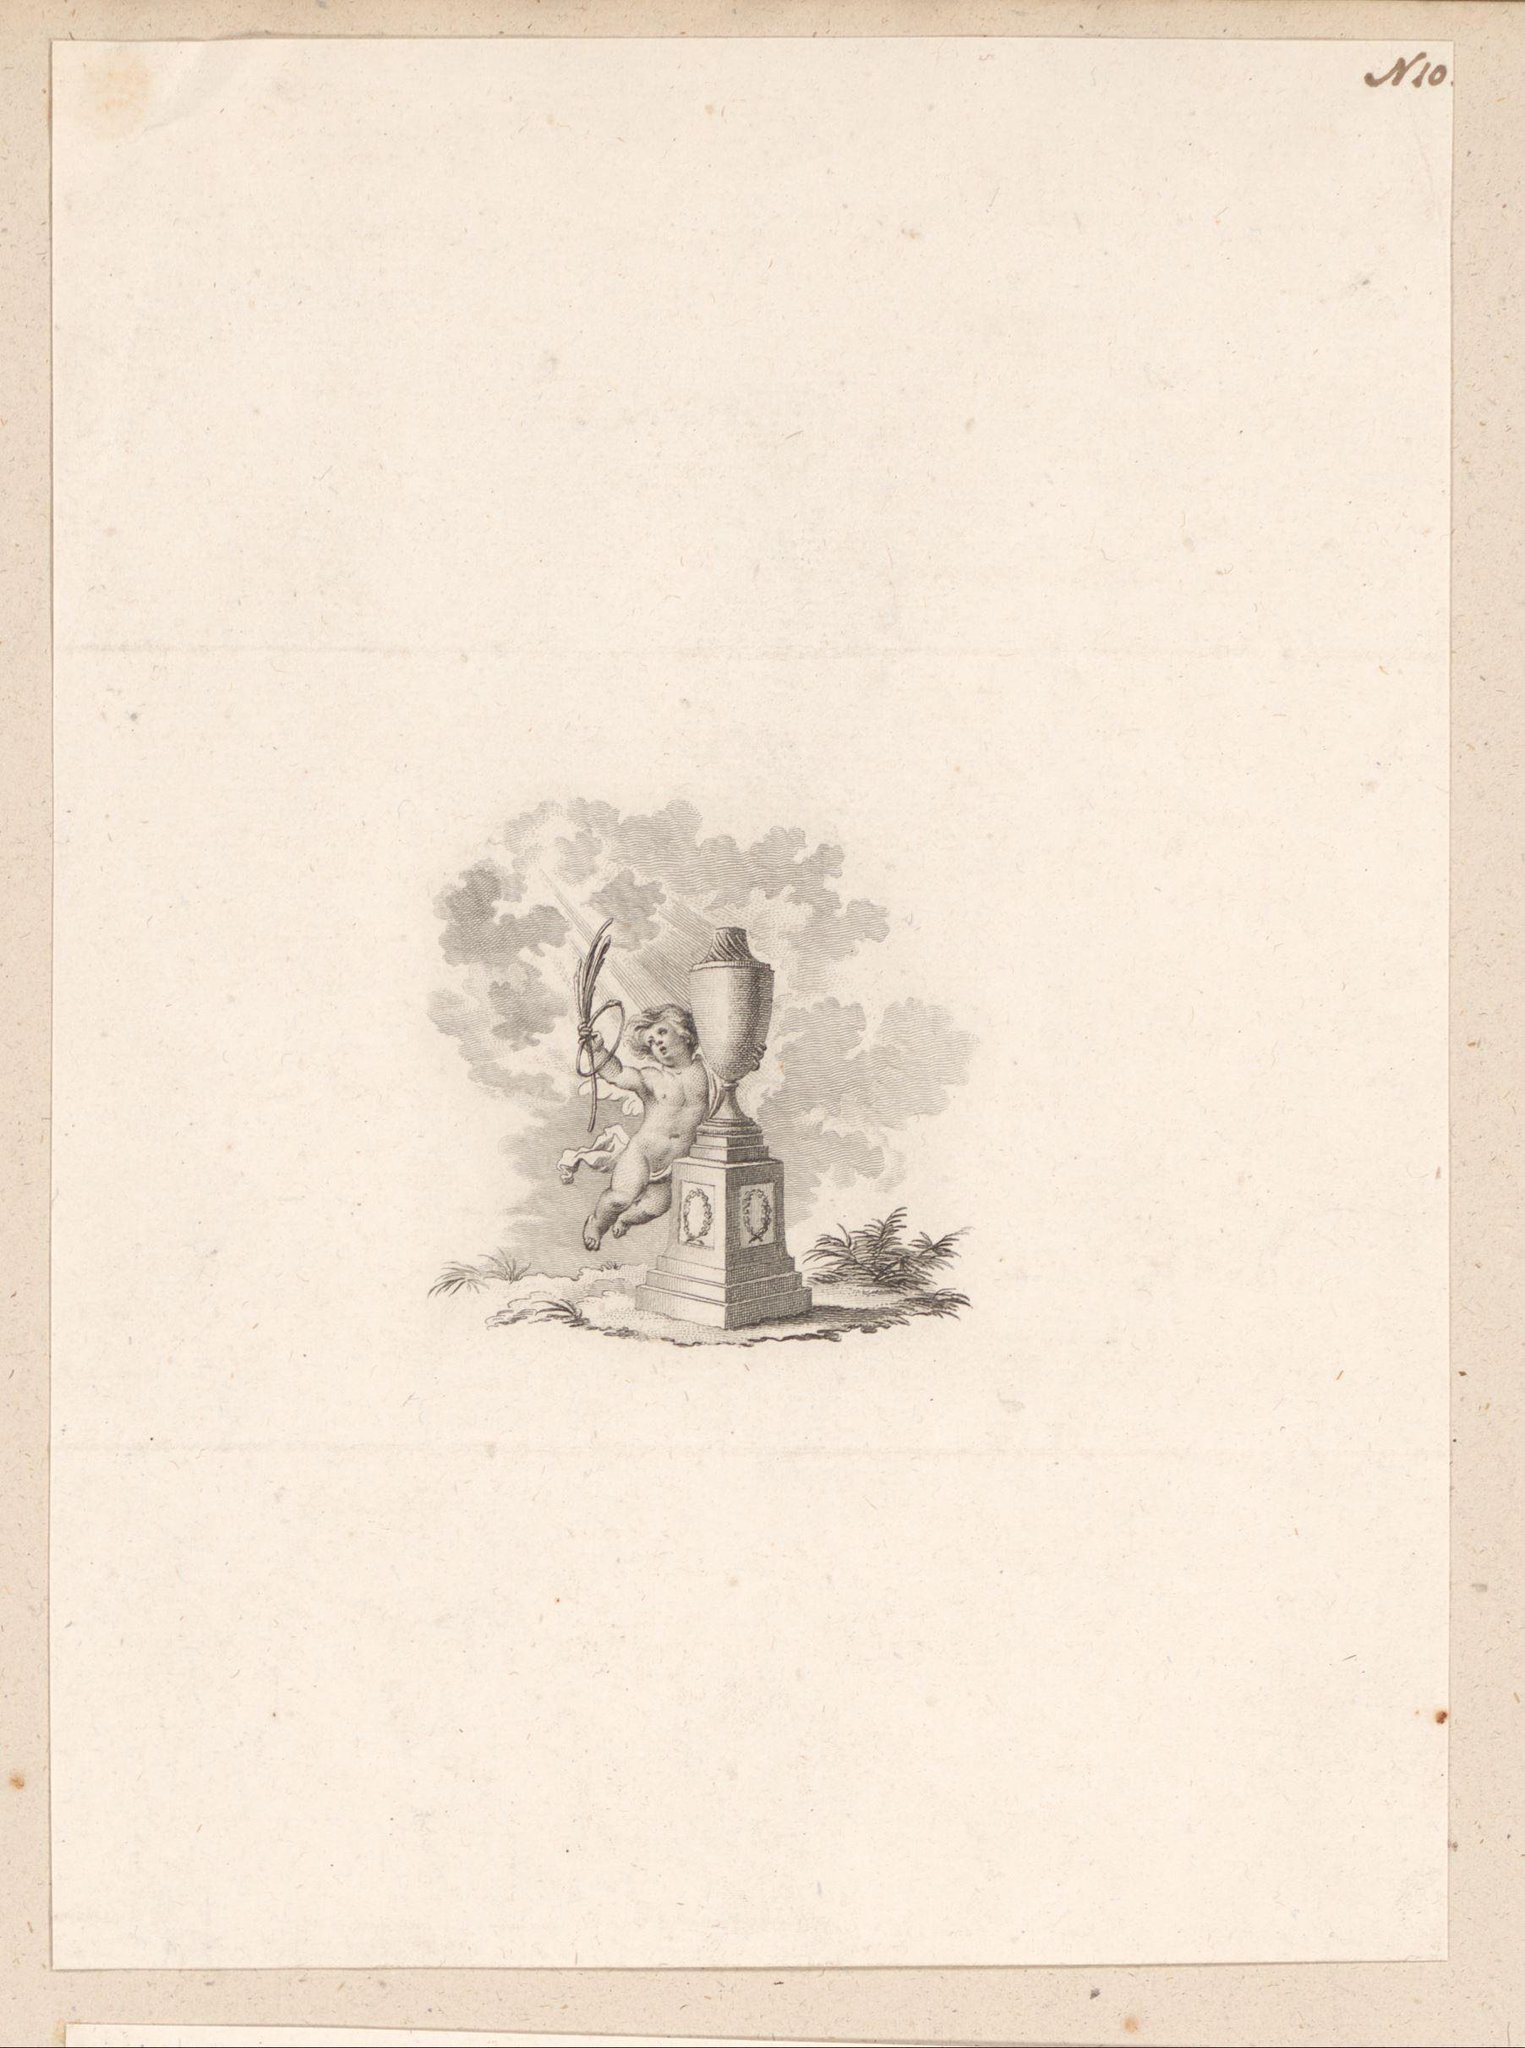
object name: titelblad, titelpagina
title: Putto met een beker op een sokkel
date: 1795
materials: paper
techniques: etching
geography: amsterdam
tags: vase ~ ornament, serpent ouroboros, cupids: 'amores', 'amoretti', 'putti'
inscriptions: inscription: ‘N10’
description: Een putto met palmtak en ouroboros (een slang die in zijn eigen staart bijt) heeft zijn arm om een beker op een sokkel geslagen. De prent maakt deel uit van een album.